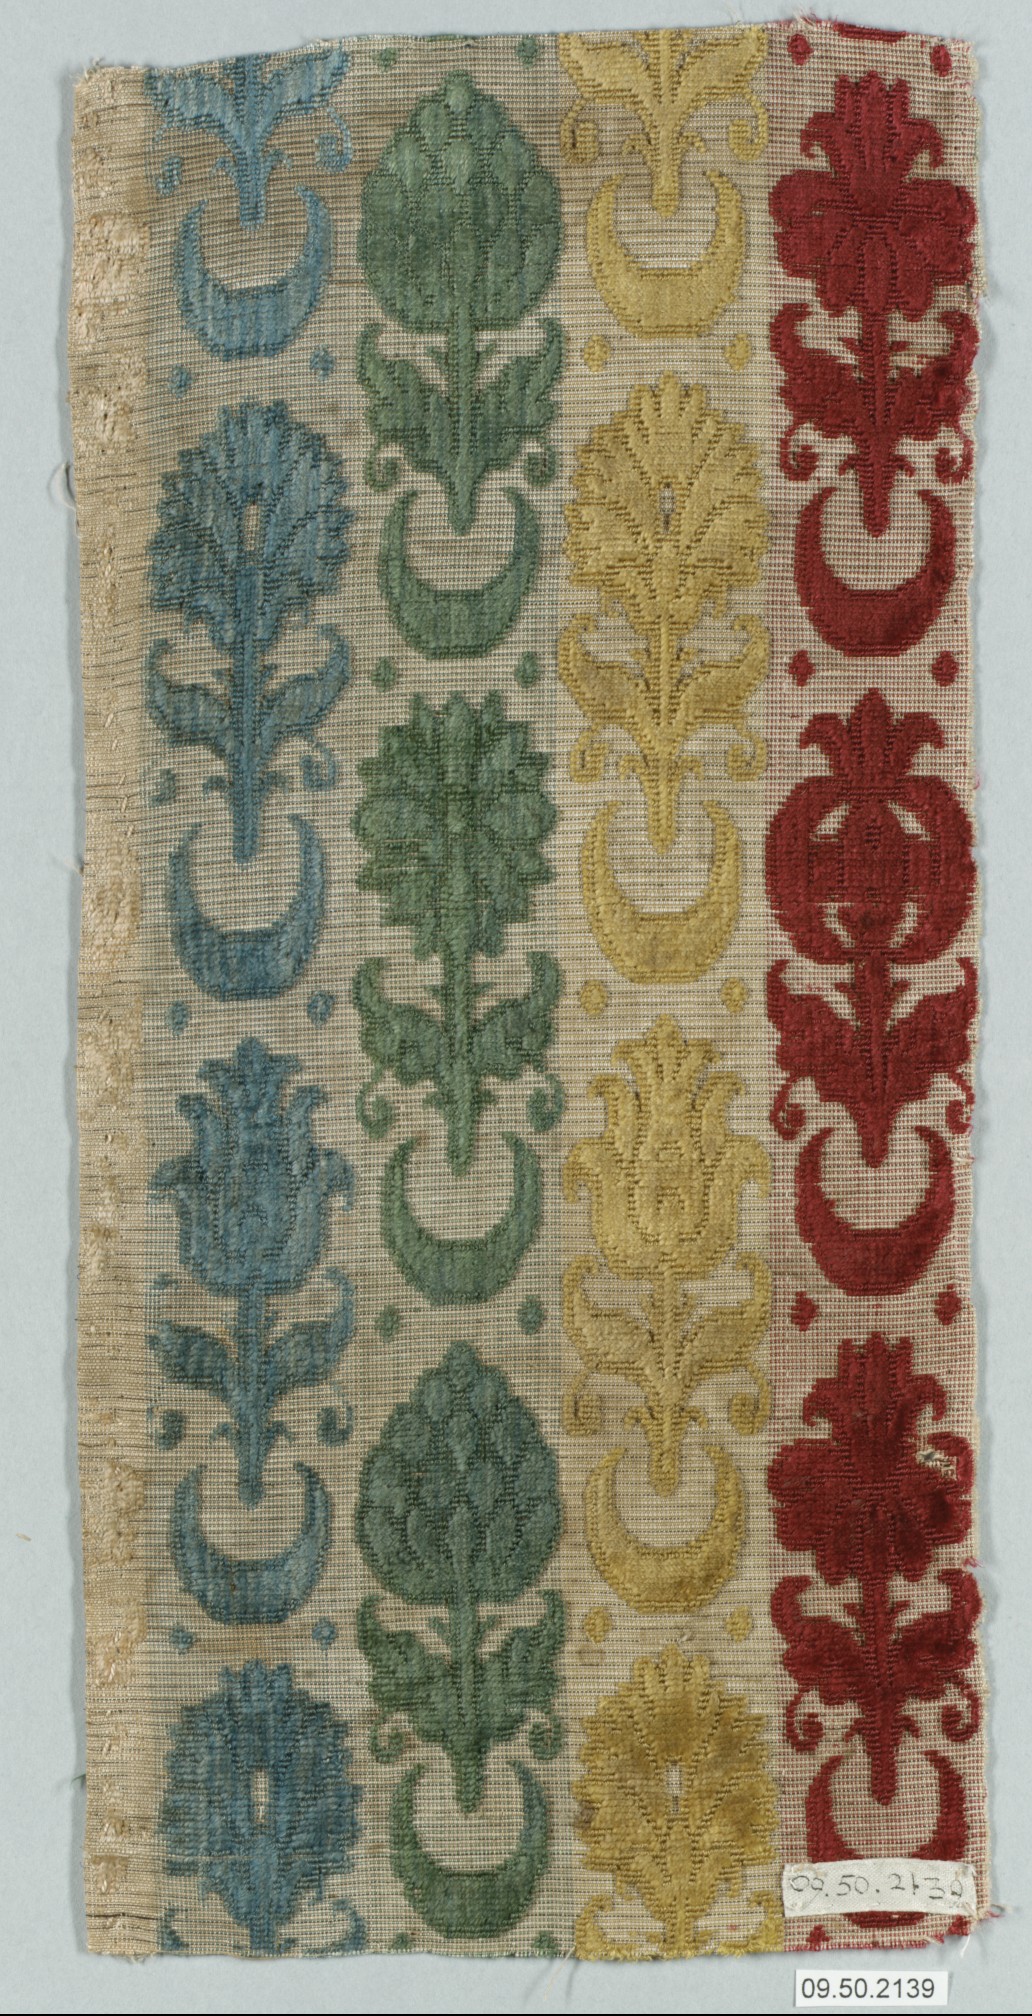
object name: piece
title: Fragment of polychrome velvet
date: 1601-1700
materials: metal thread, silk, velvet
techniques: cutting, voiding